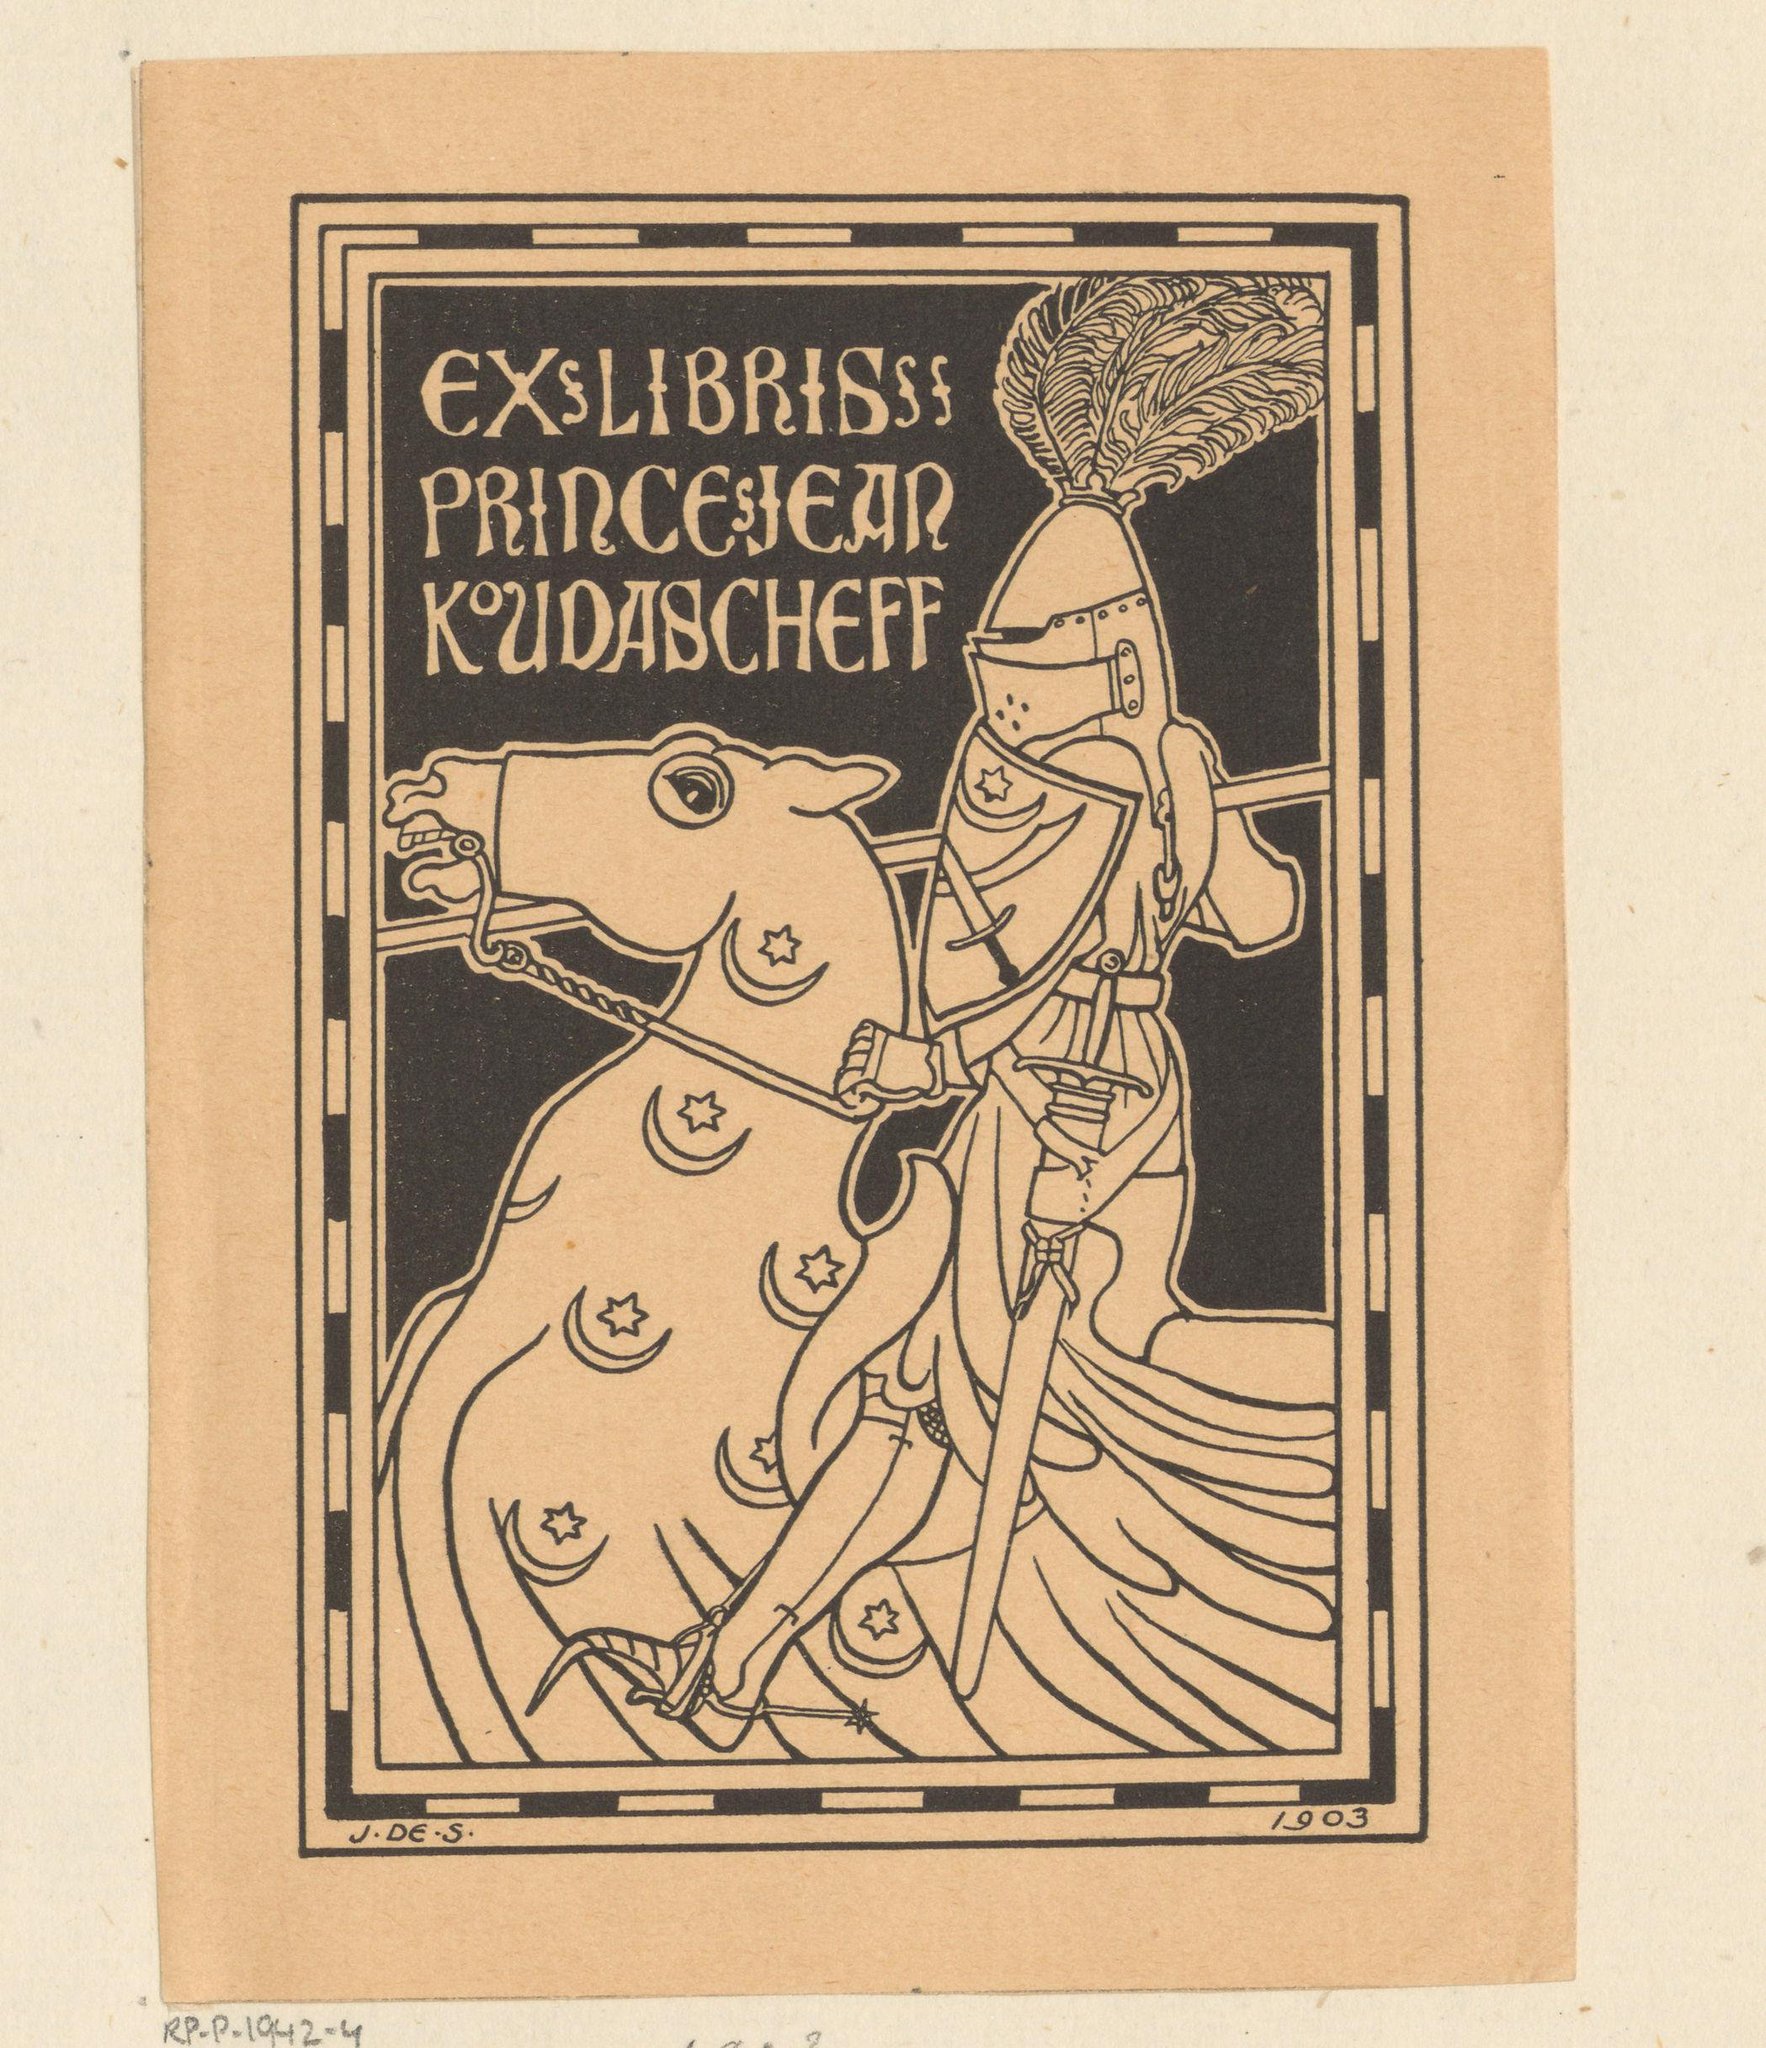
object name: bookplate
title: Ex libris van Prince Jean Koudascheff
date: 1903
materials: paper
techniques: printing block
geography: england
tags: horse, knight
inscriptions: date